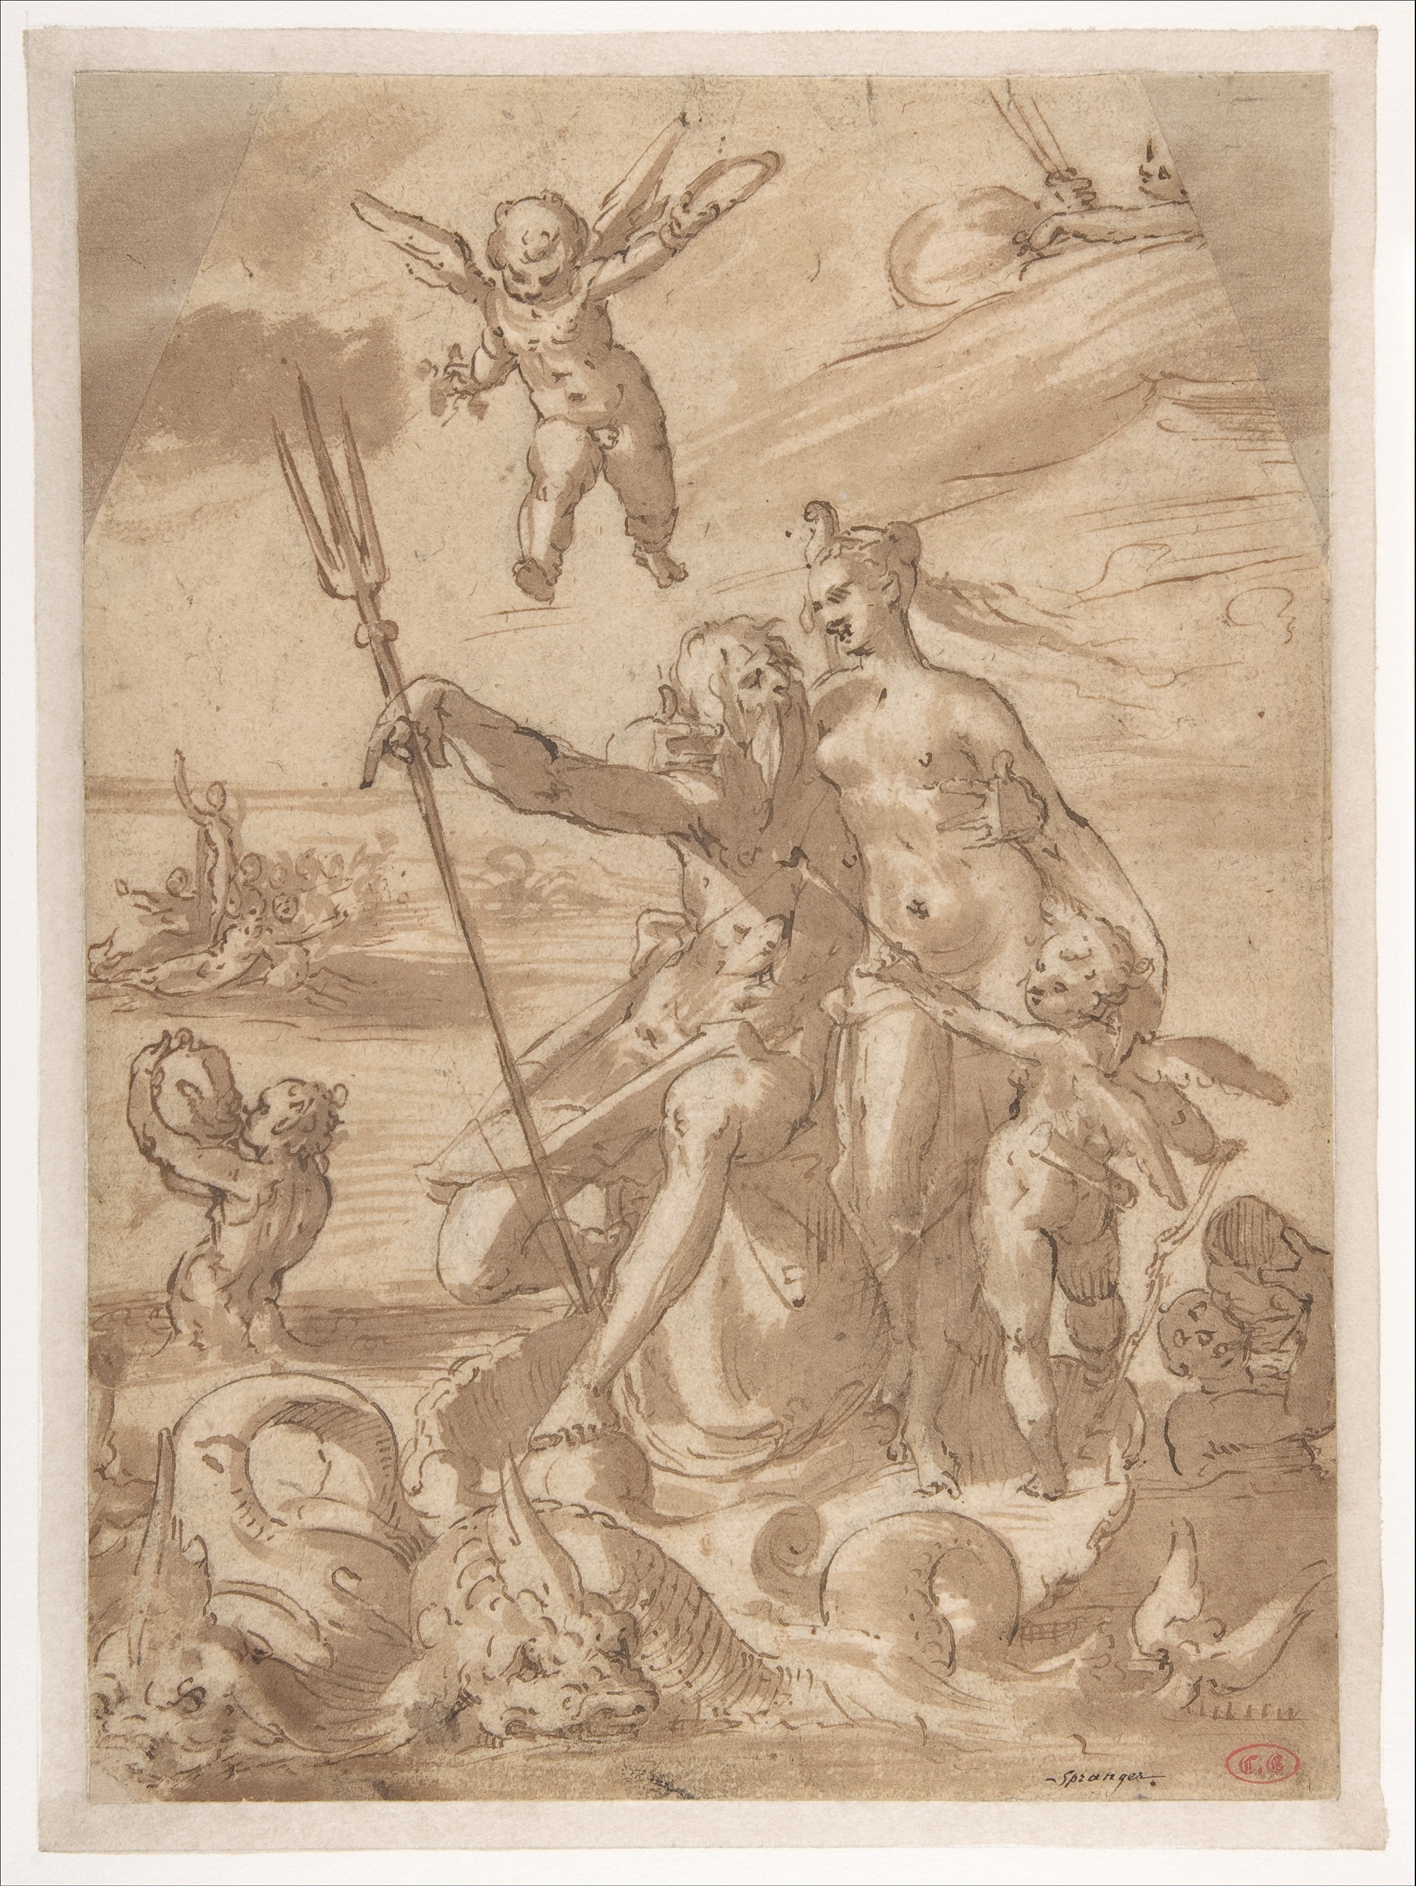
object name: drawing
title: Neptune and Amphitrite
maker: bartholomeus spranger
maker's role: artist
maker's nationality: netherlandish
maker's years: 1546-1611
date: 1534-1633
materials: ink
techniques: pen, wash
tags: female nudes,putti,neptune